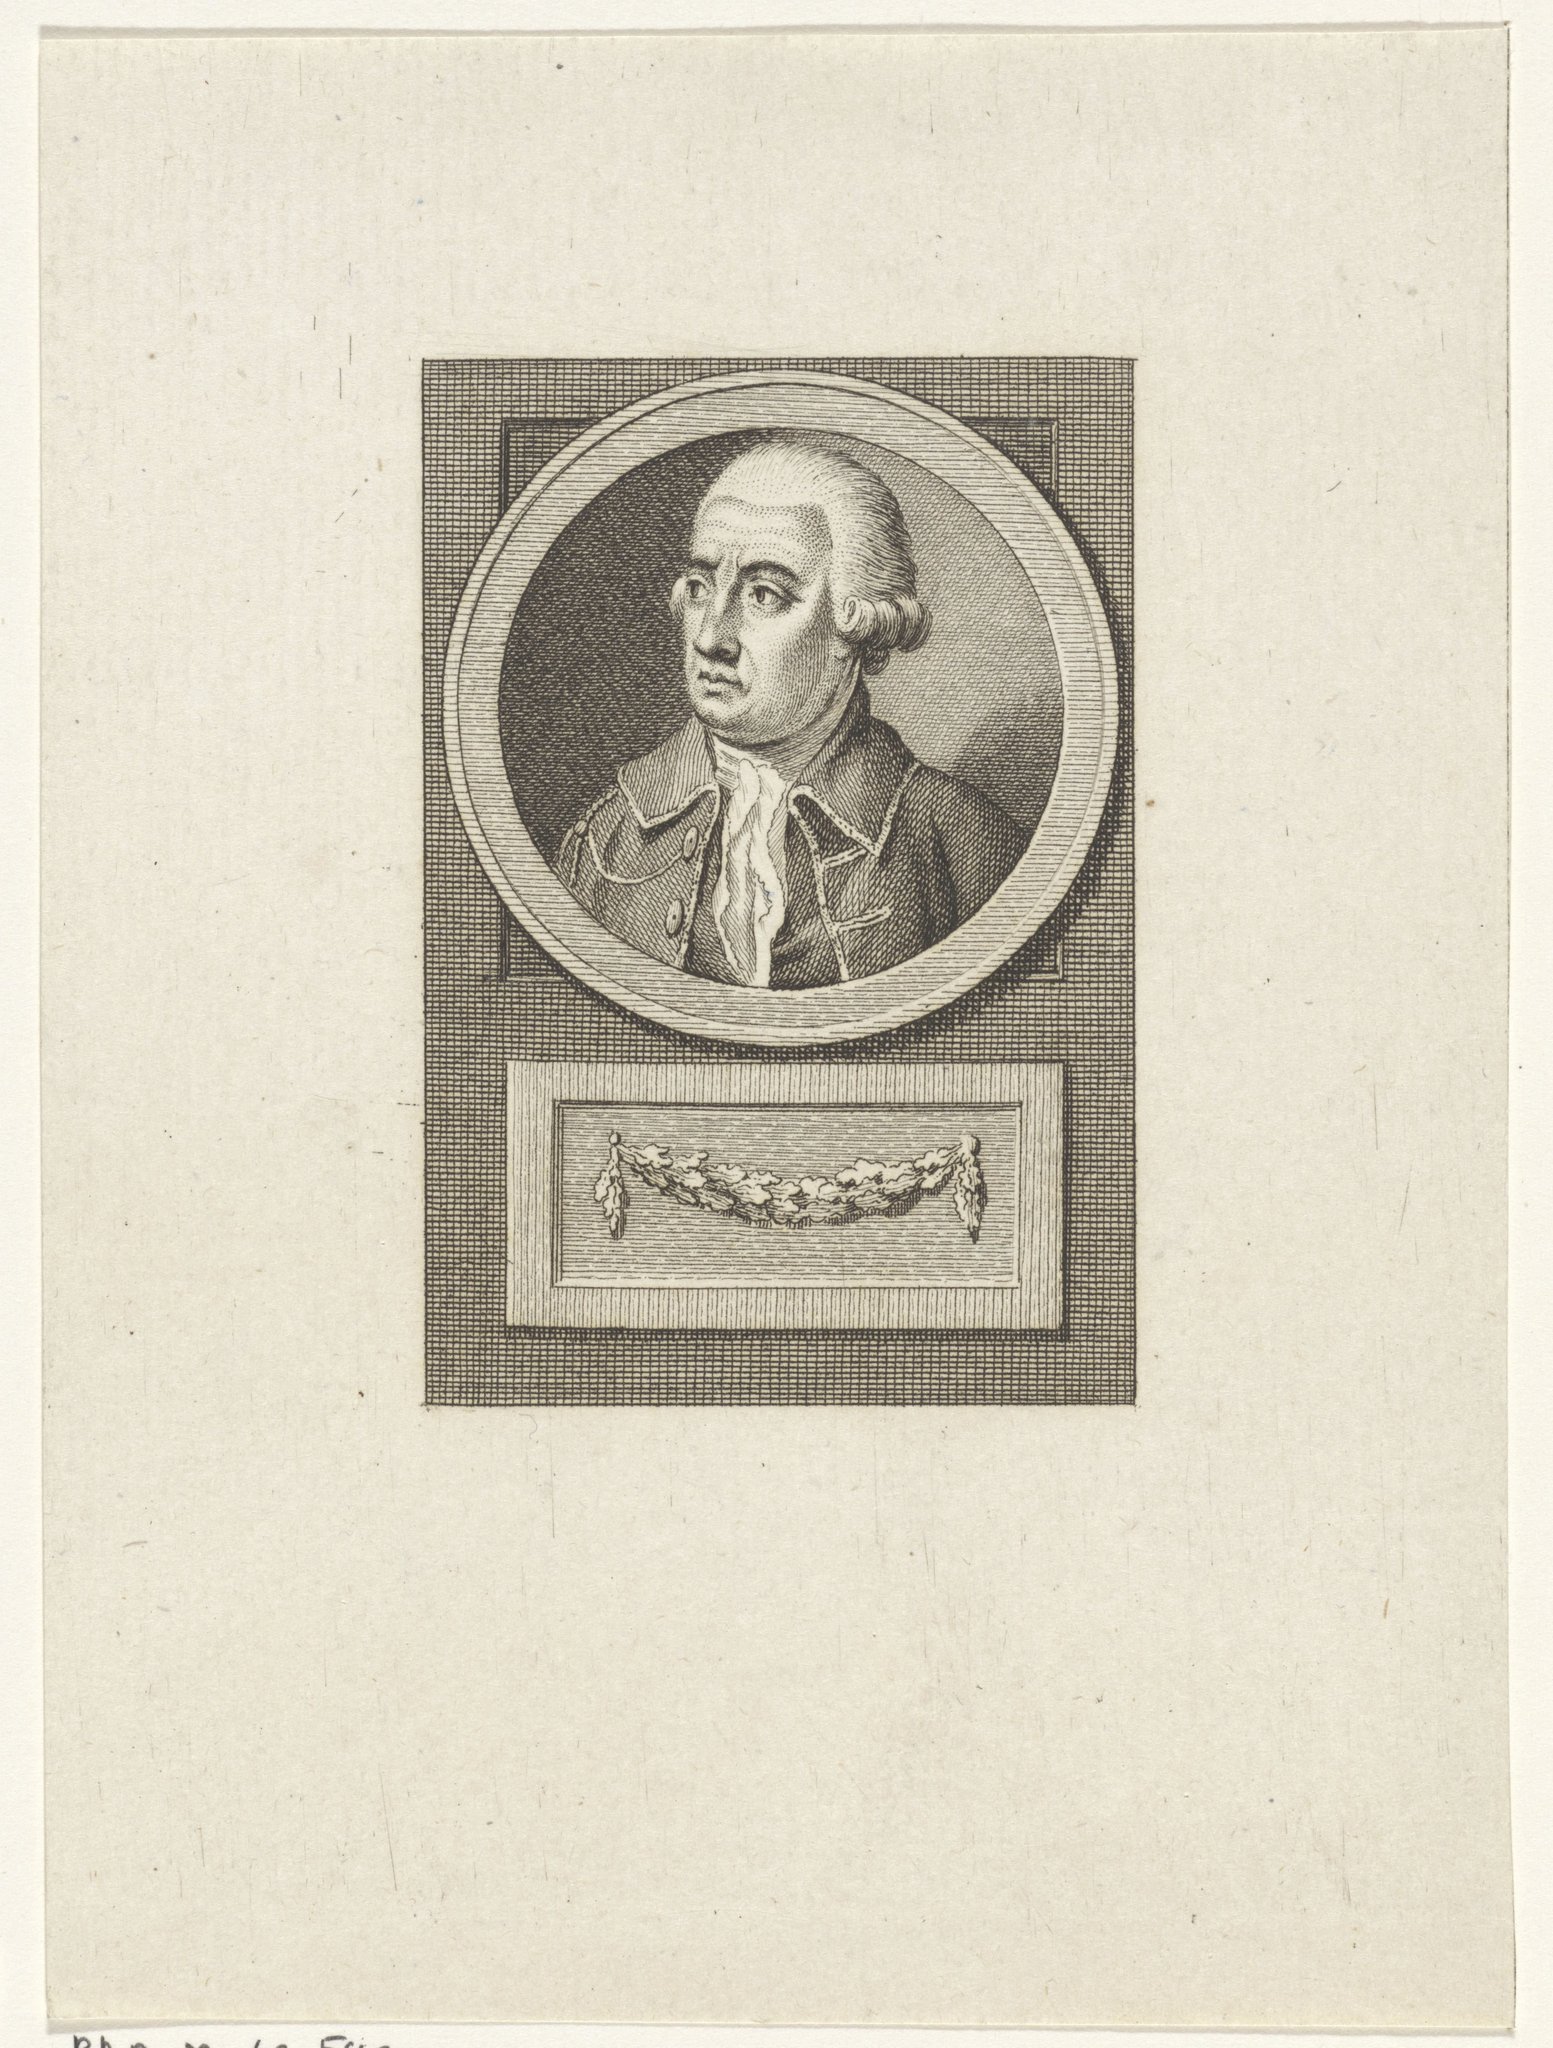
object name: print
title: Portret van Jean André van der Mersch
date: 1783-1795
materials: paper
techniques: engraving, etching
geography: amsterdam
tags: menen, dadizele, jan andries vander mersch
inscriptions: collector's mark: Lugt 2228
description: Latere staat prent gebruikt in: Fokke, Jan. Geschiedenissen der Vereenigde Nederlanden voor de vaderlandsche jeugd Ie-XXVste deel. Amsterdam: Johannes Allart, 1783-1795. Deel XXIII.